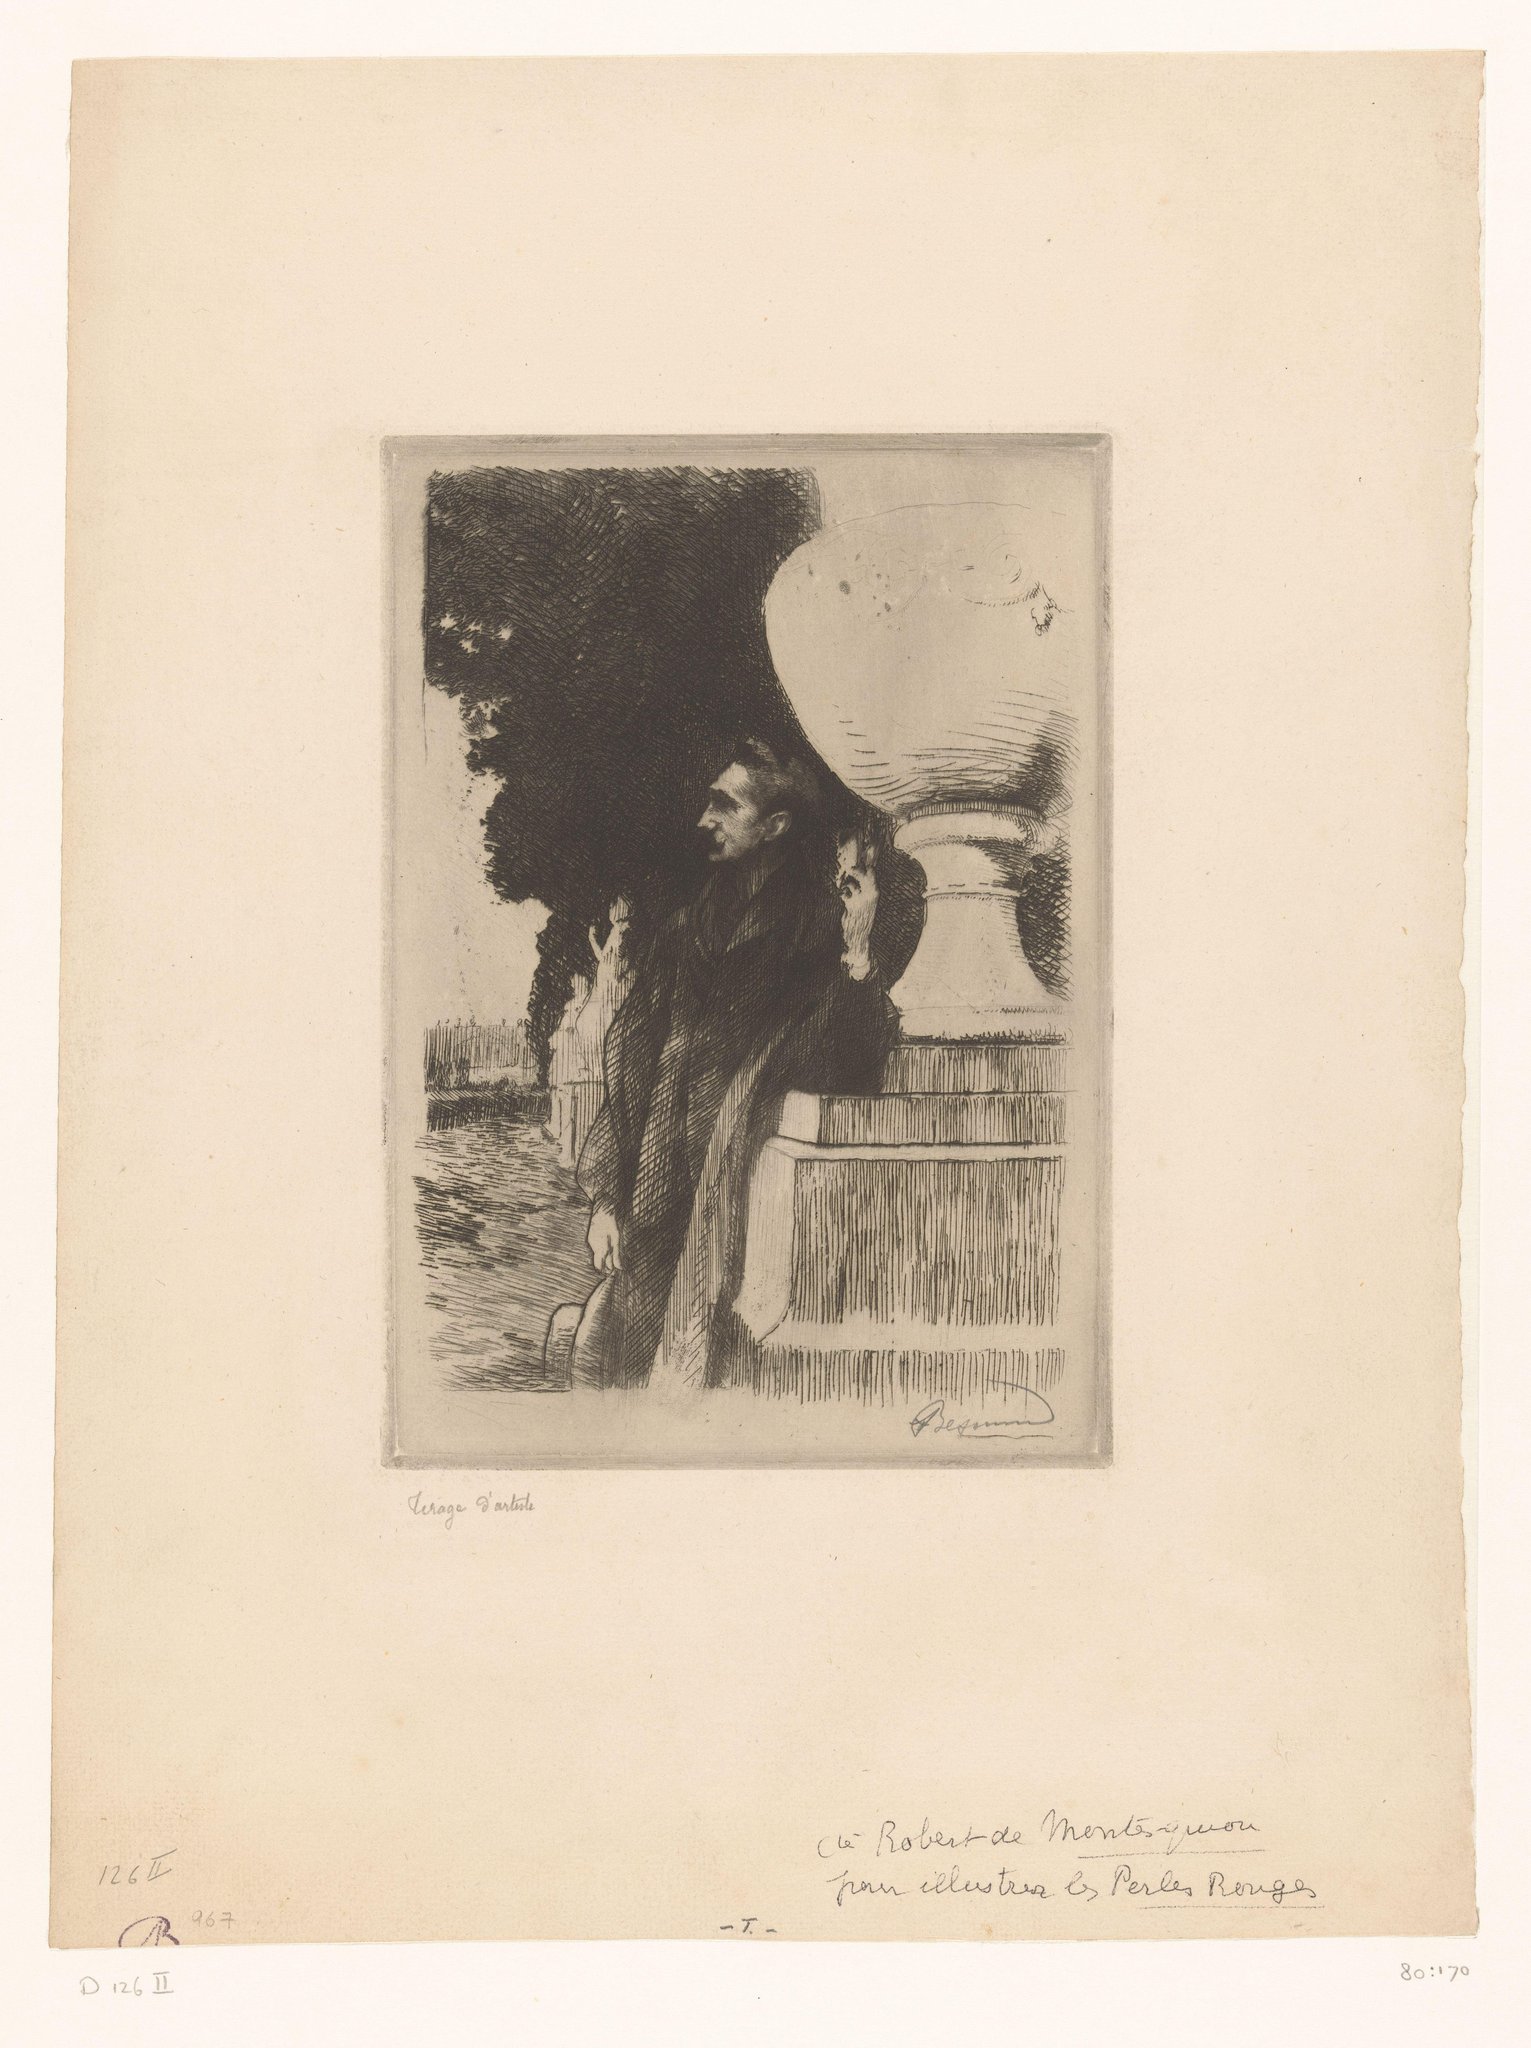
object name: print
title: Portret van Robert de Montesquiou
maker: albert besnard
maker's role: draughtsman, print maker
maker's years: 1849-1934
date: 1859-1934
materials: paper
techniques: drypoint, etching, intaglio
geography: france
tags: paris, historical persons, french or architectonic garden; formal garden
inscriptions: watermark, collector's mark: Lugt 67a, collector's mark: Lugt 2228, collector's mark: Lugt 2760